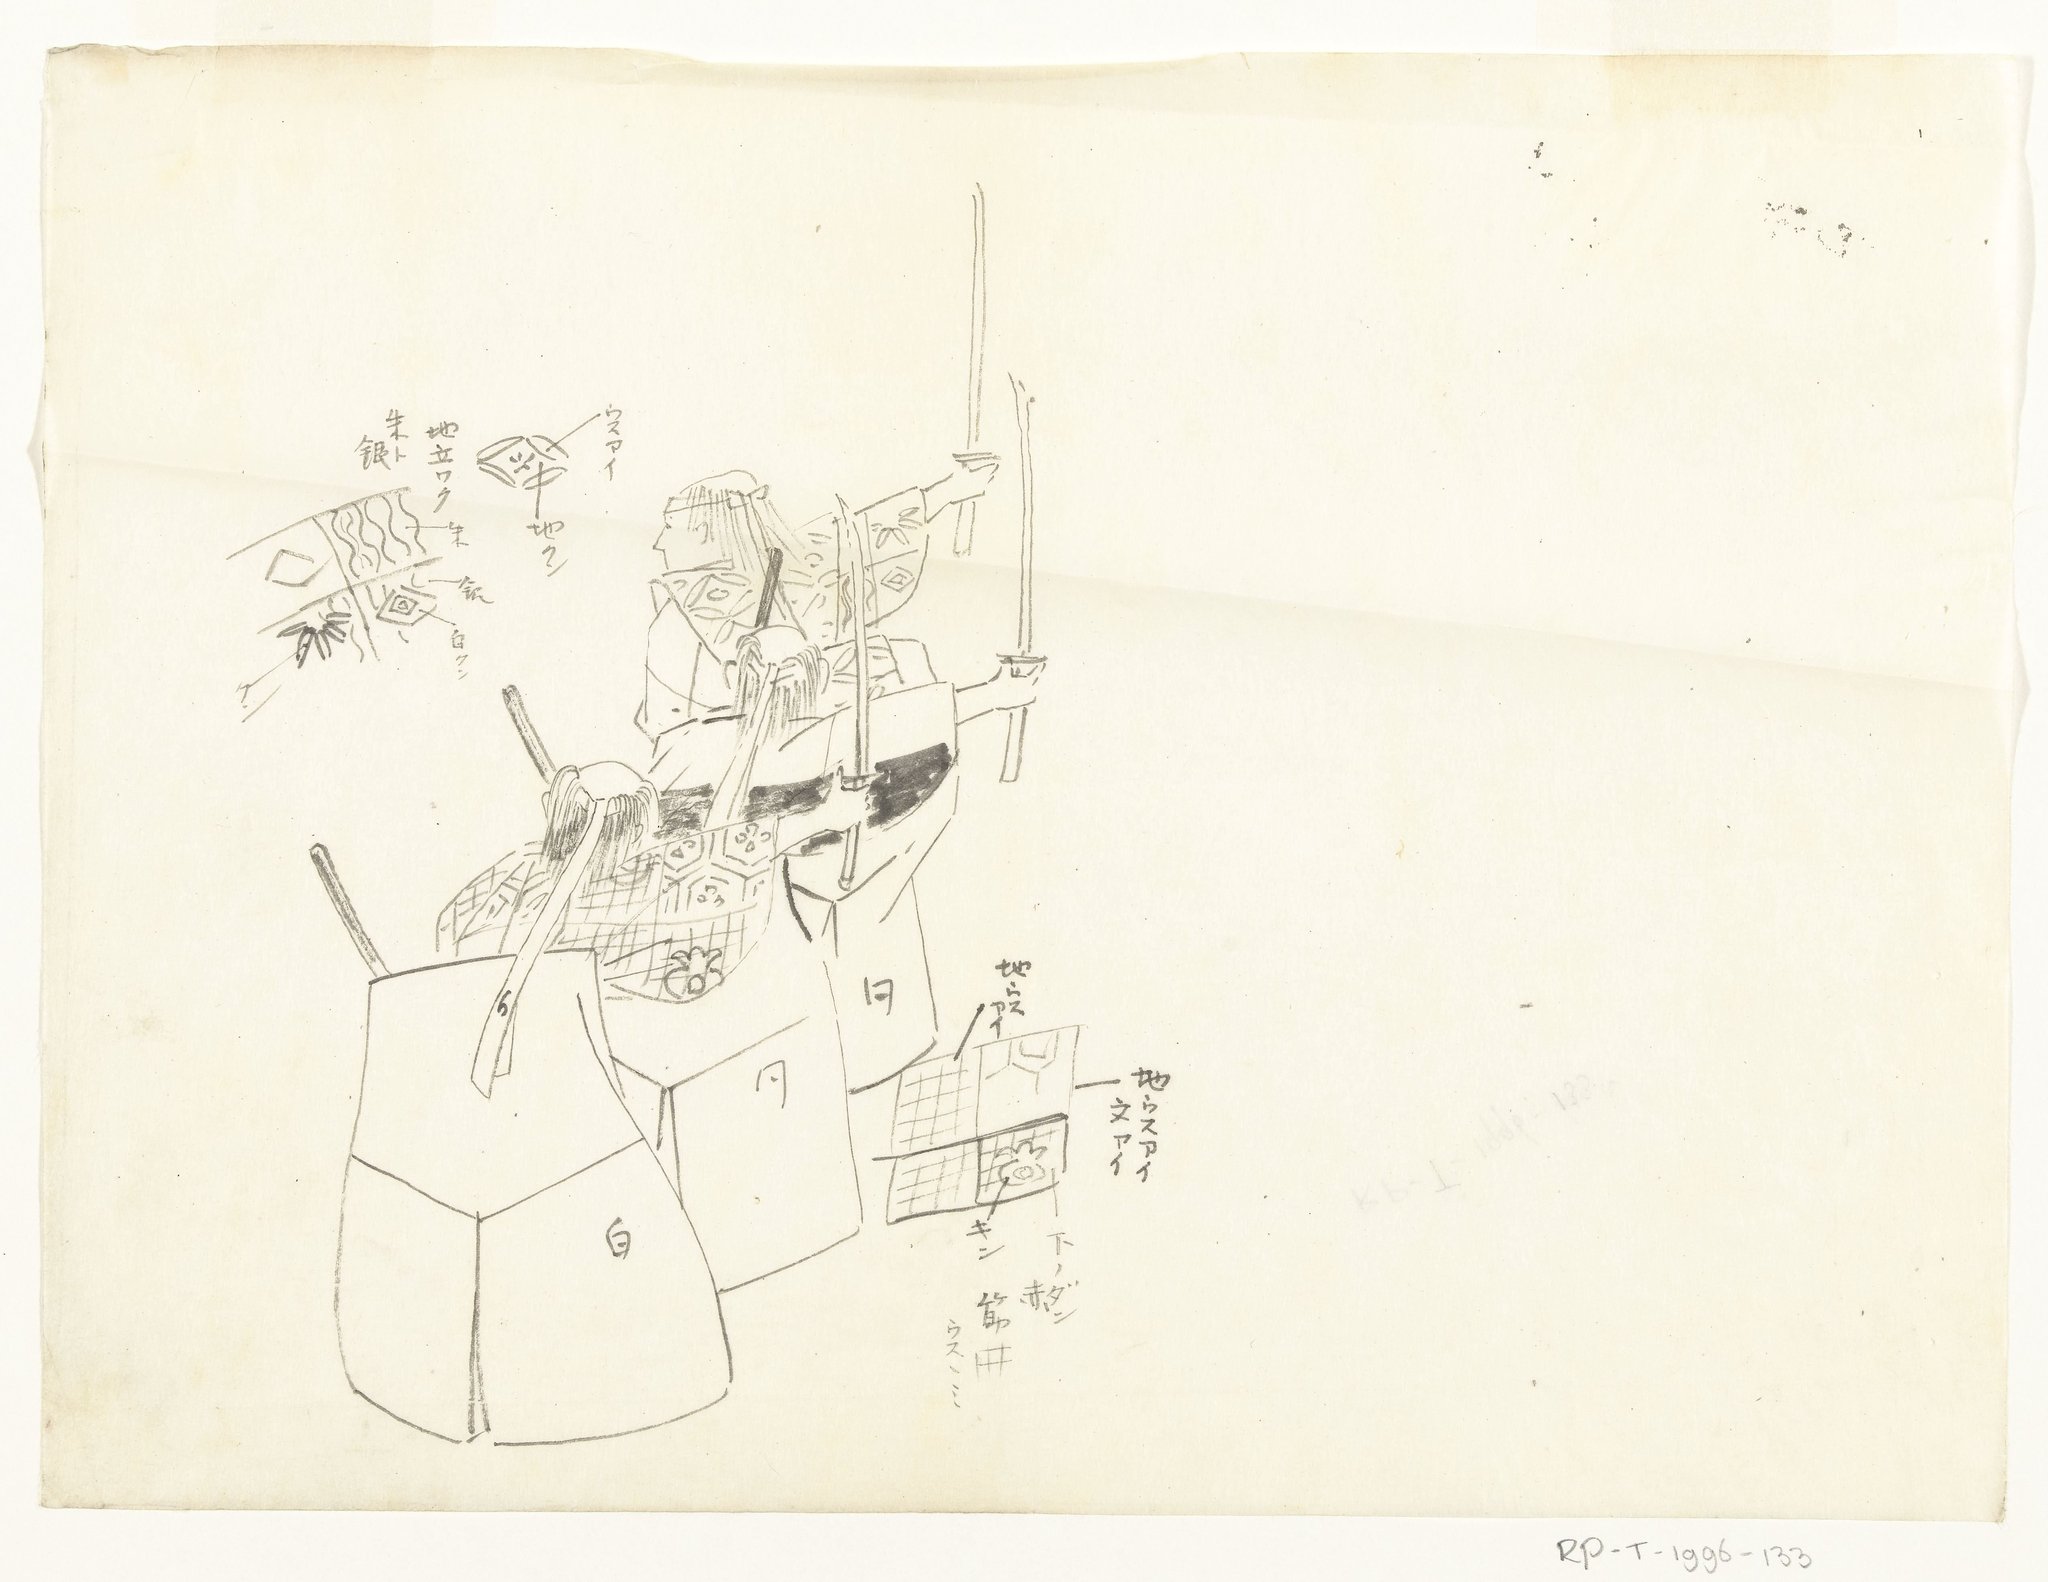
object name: preliminary drawing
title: Scene uit het Noh theaterstuk Tsuchigumo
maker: tsukioka kôgyo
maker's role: print maker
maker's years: 1869-1927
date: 1902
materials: paper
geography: japan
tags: theatre, theatrical performance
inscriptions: : ‘.’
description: Drie Japanse acteurs met getrokken zwaarden, op de rug gezien. Bij de tekening aanwijzingen met betrekking tot kleur en details. Voortekening van een kleurenhoutsnede.